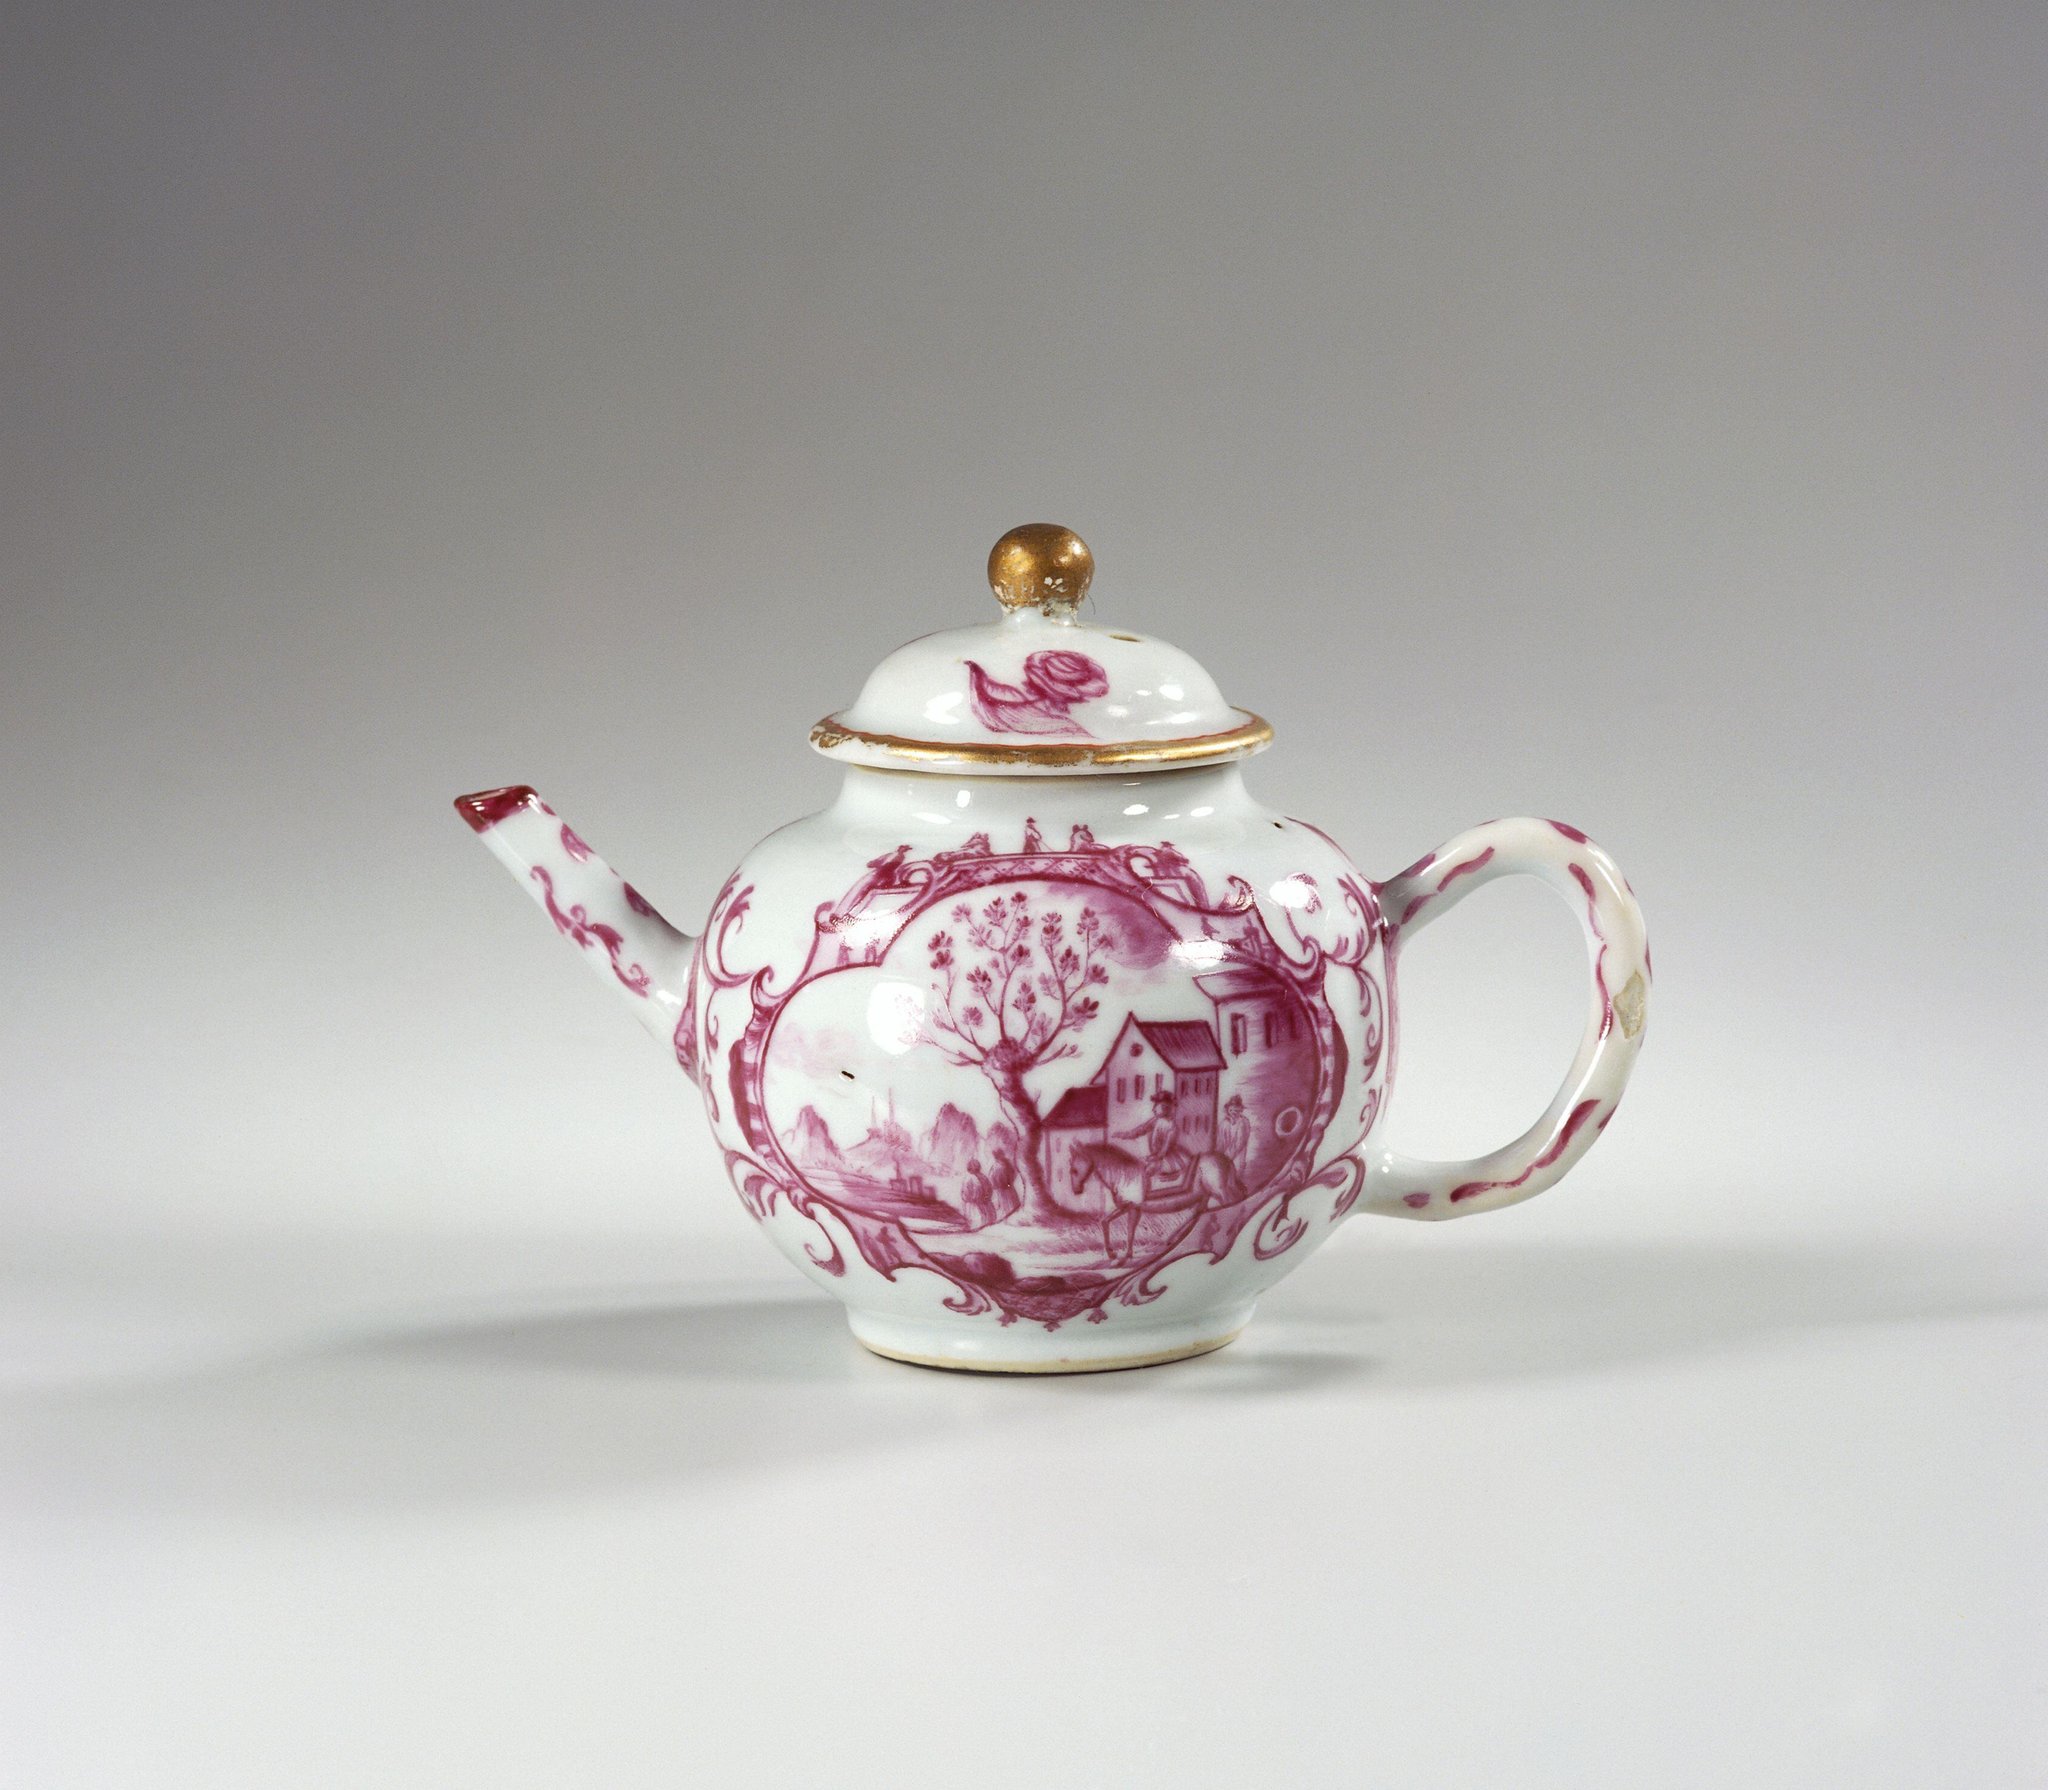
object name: lid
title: Teapot with two panels with European scenes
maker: Anonymous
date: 1725-1774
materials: glaze, gold, paint, porcelain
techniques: firing, gilding, turning, vitrification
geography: meissen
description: Deksel van theepot van porselein, beschilderd op het glazuur in roze (en camaïeu). Op de deksel drie rozen. Dekselknop gebroken geweest. In Europa gedecoreerd.